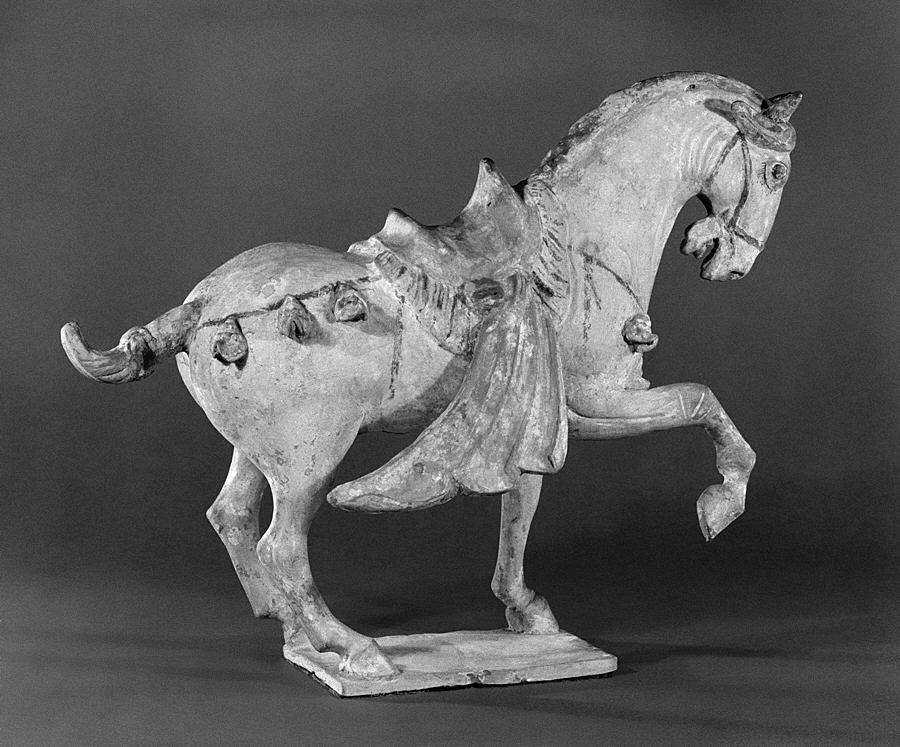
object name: figure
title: Figure of a horse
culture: chinese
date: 601-800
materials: earthenware, pigment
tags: horses